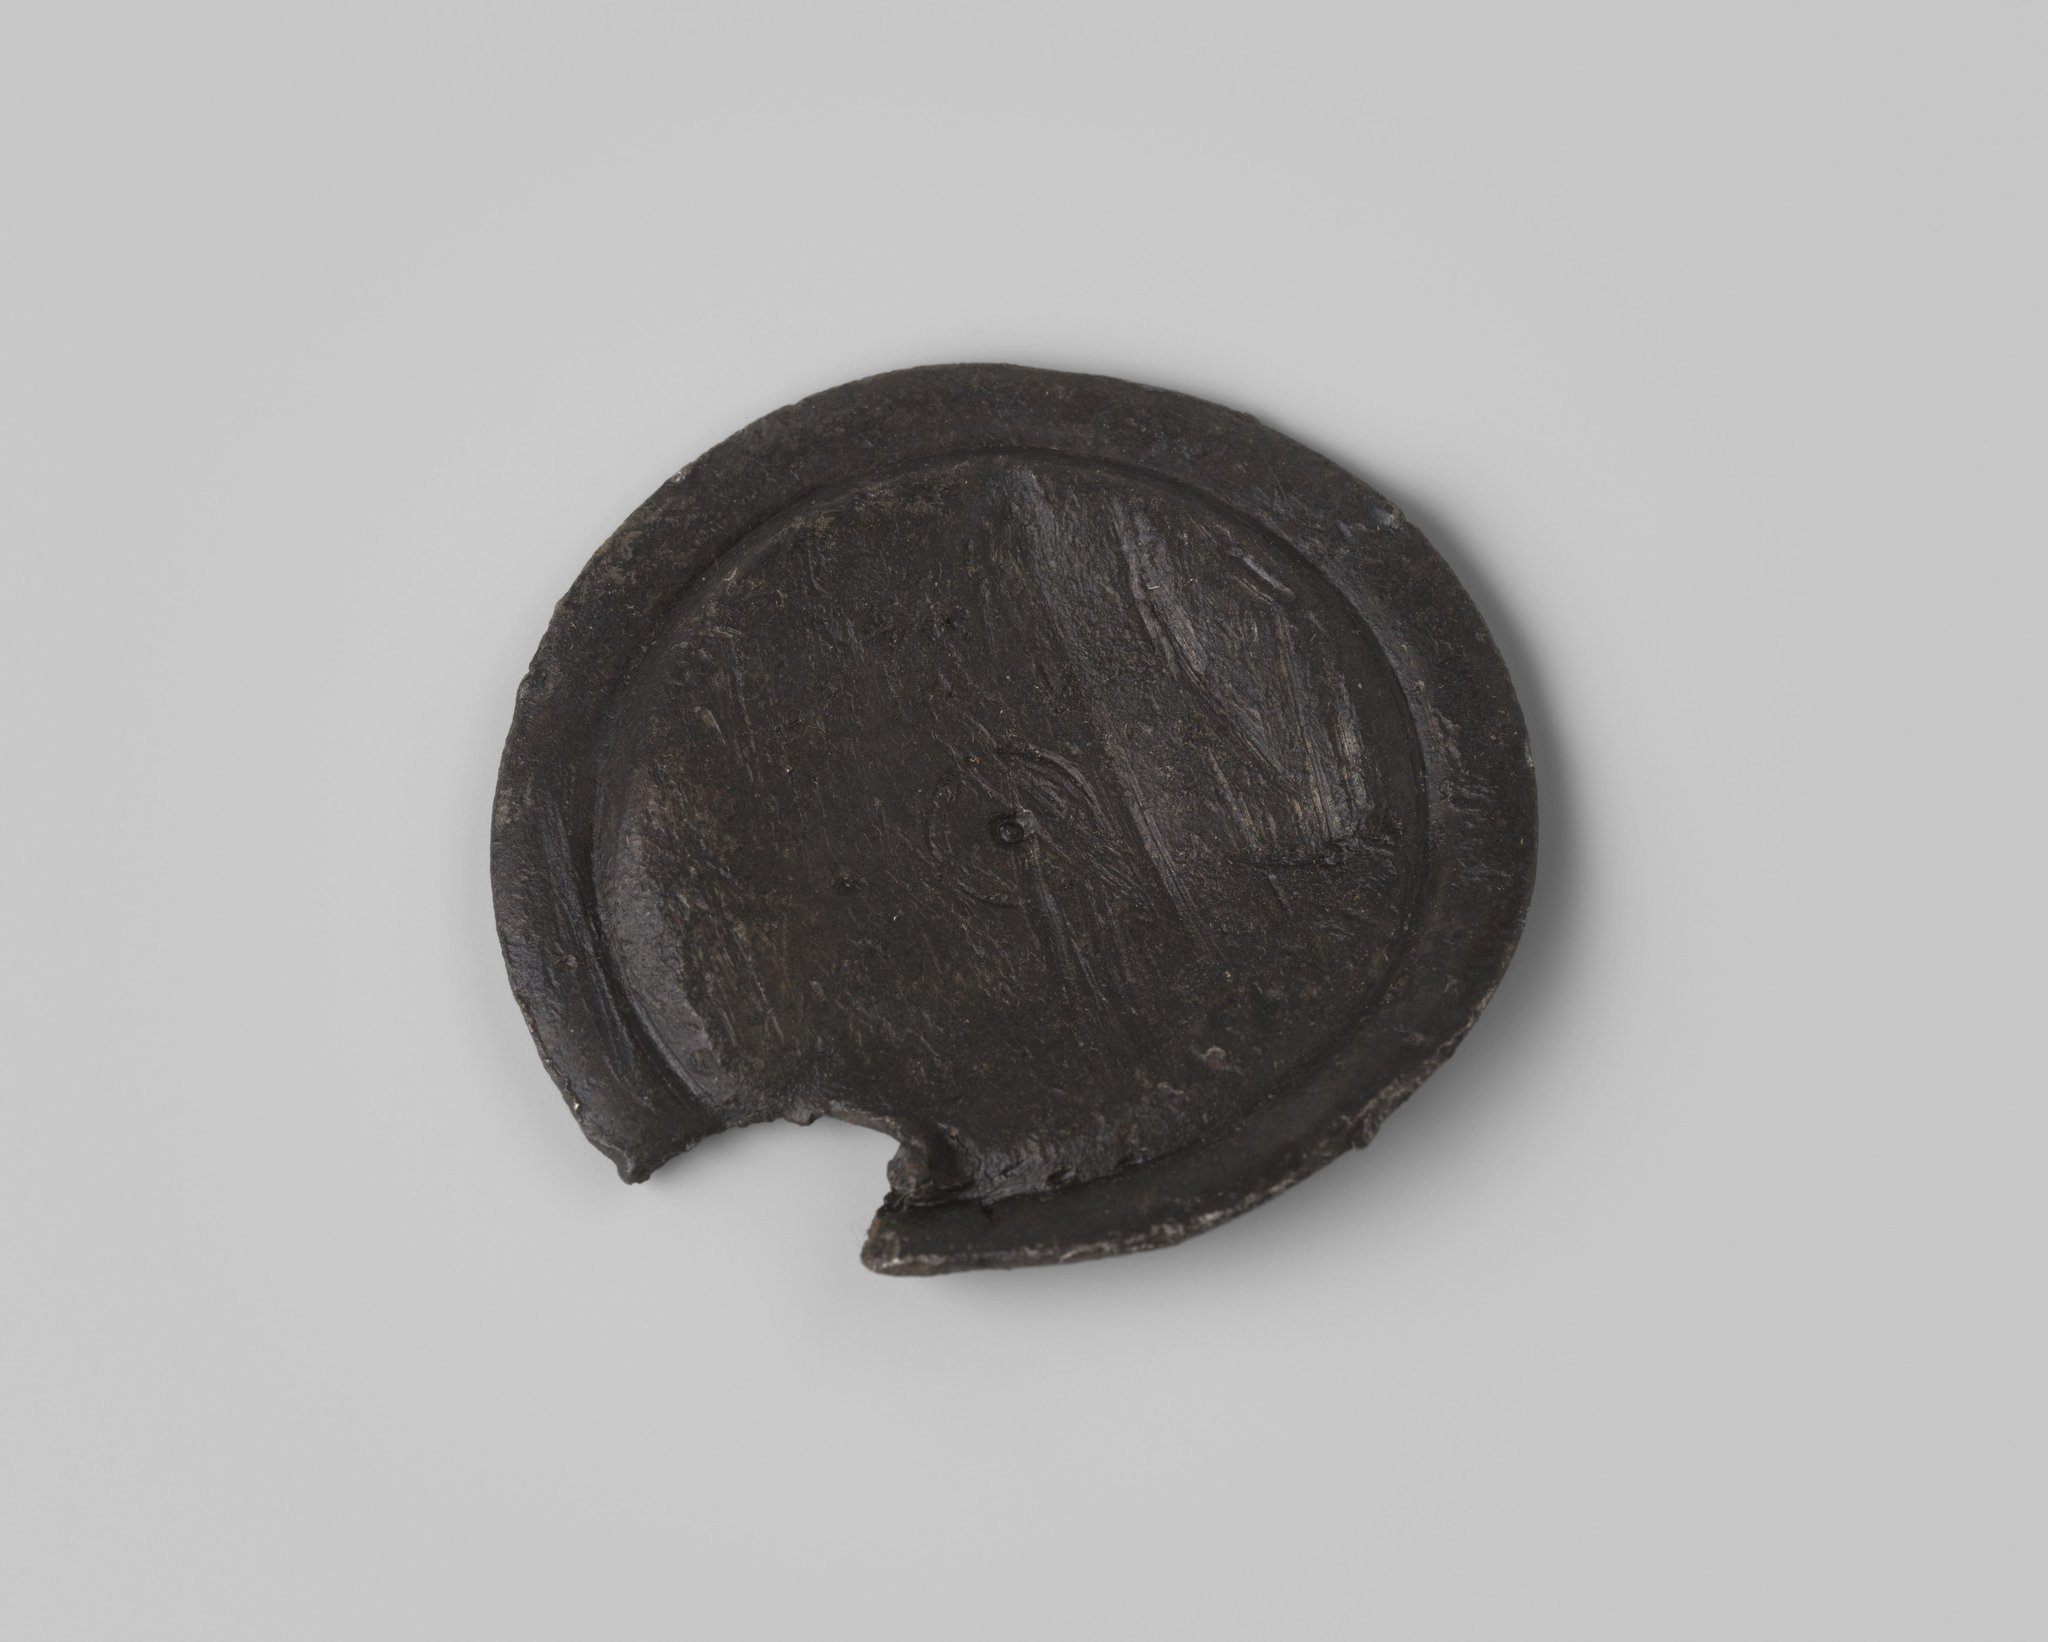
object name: lid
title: Deksel van een kan uit het wrak van de Oost-Indiëvaarder Hollandia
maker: Anonymous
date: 1700-1743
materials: tin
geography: netherlands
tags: verenigde oostindische compagnie, hollandia (schip), annet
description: Jug, lid, id. NG 1980-27H1430, mark on the inside [coat of arms of Amsterdam with lion rampant].